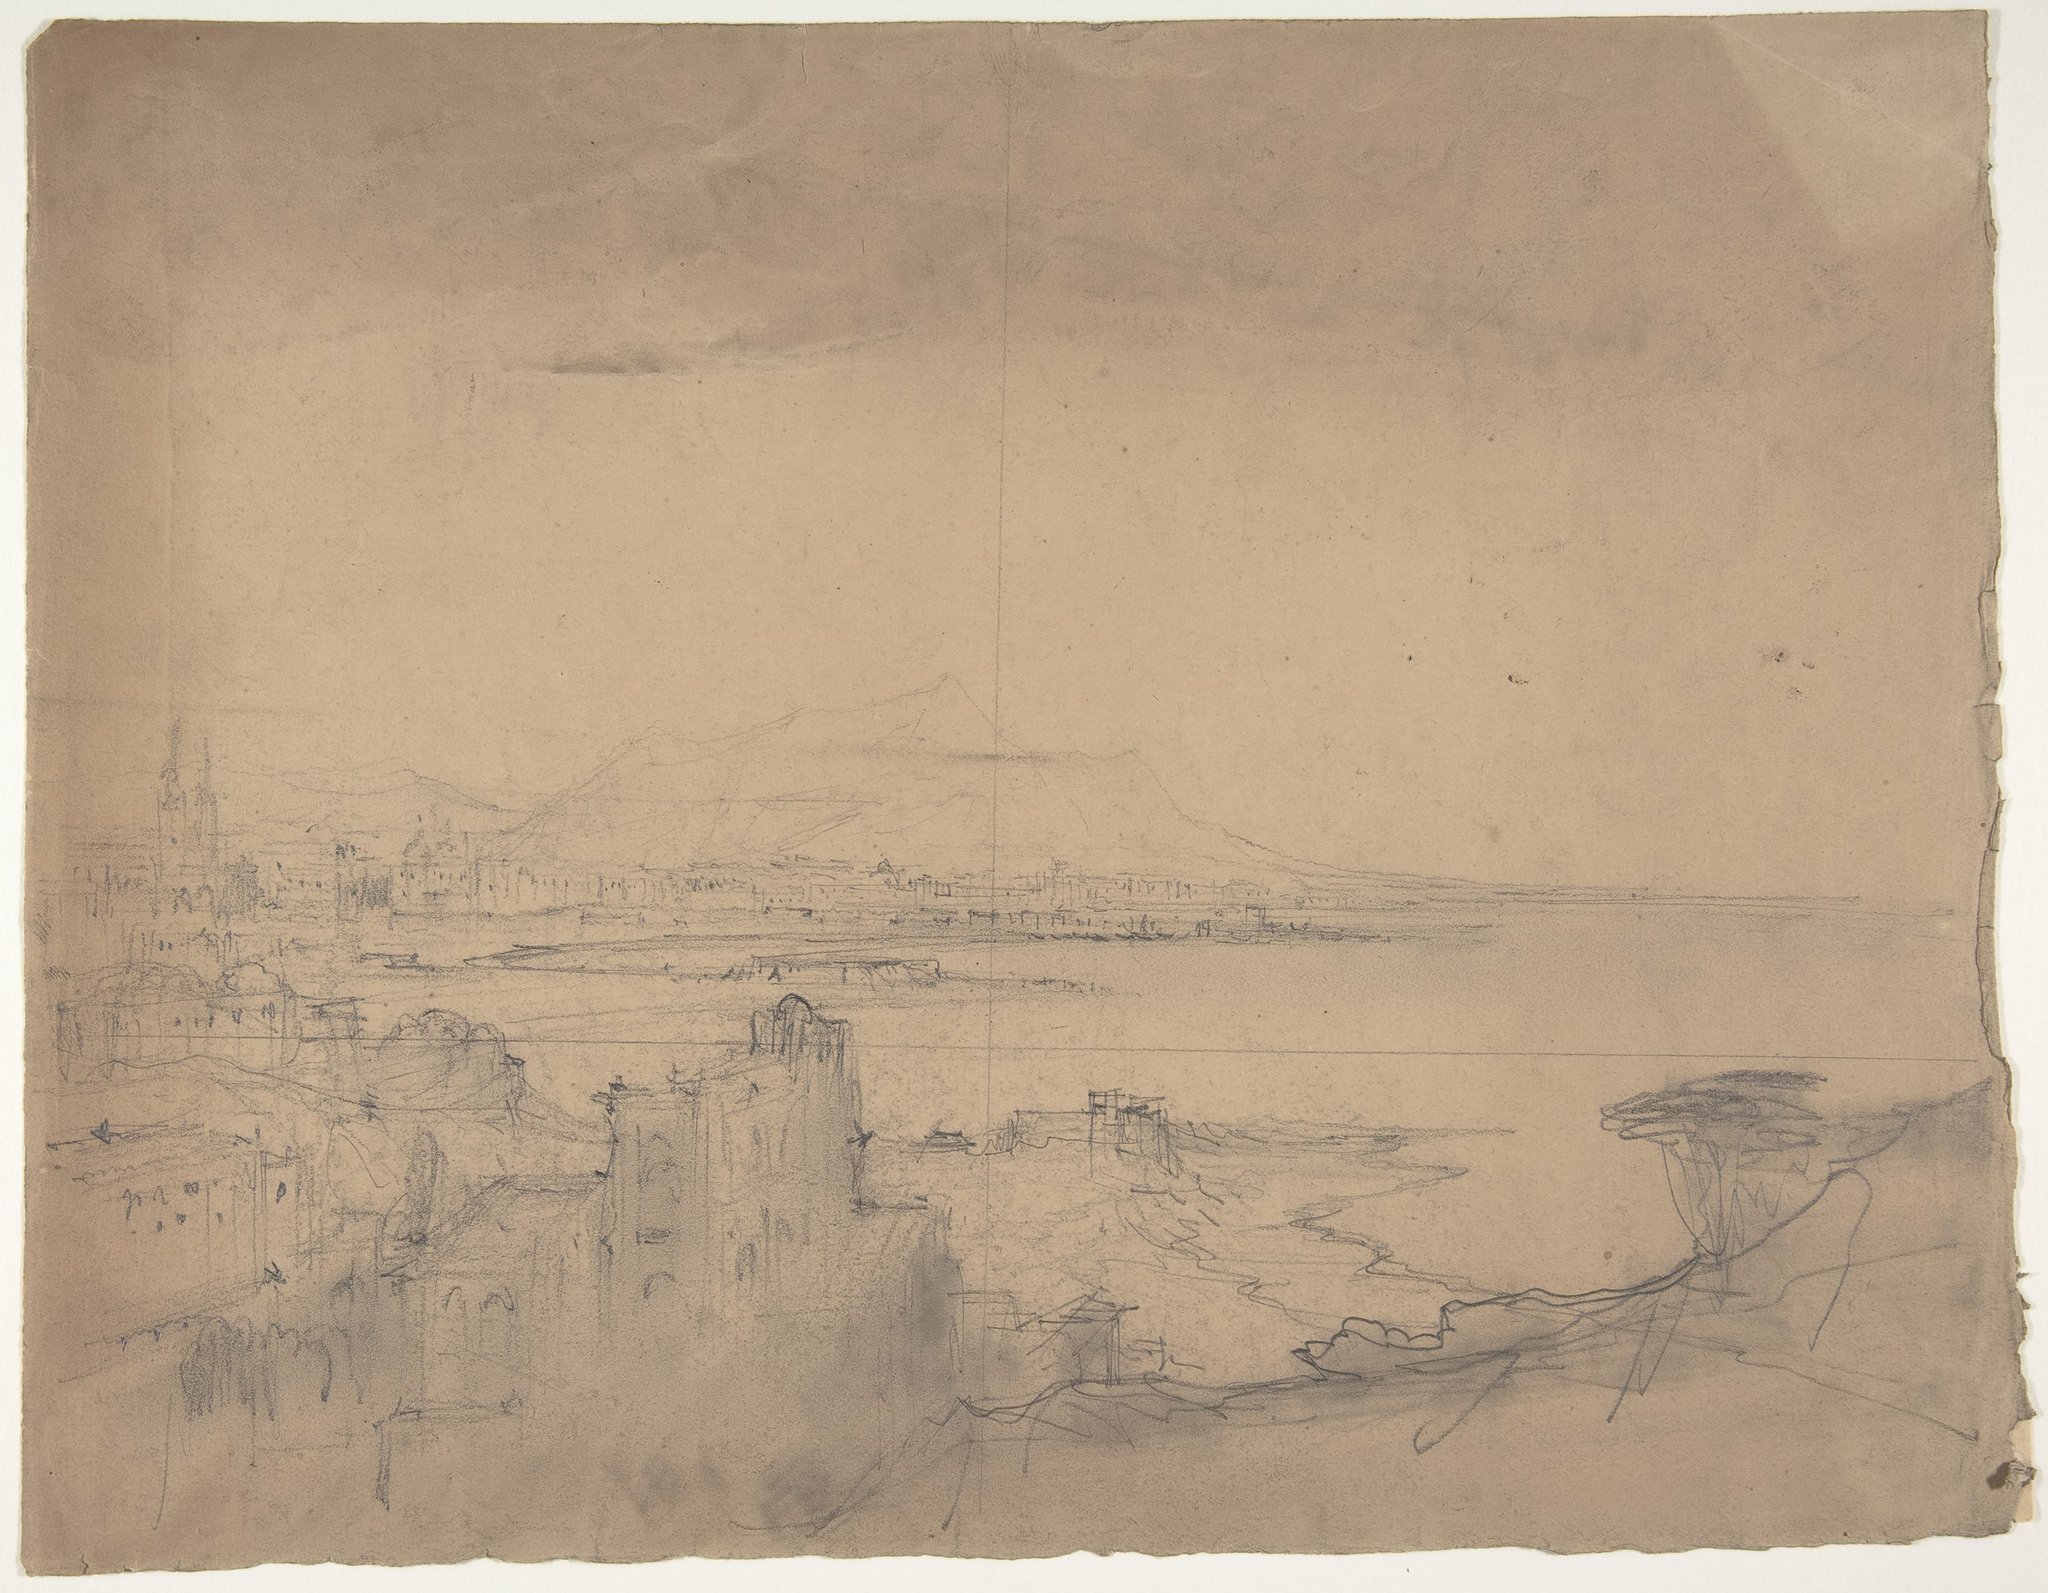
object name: drawing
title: Design for a Stage Set at the Opéra, Paris (recto); Man with Cane (verso)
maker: eugène cicéri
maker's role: artist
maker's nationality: french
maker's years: 1813-1890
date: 1840-1890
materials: graphite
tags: landscapes,stage design